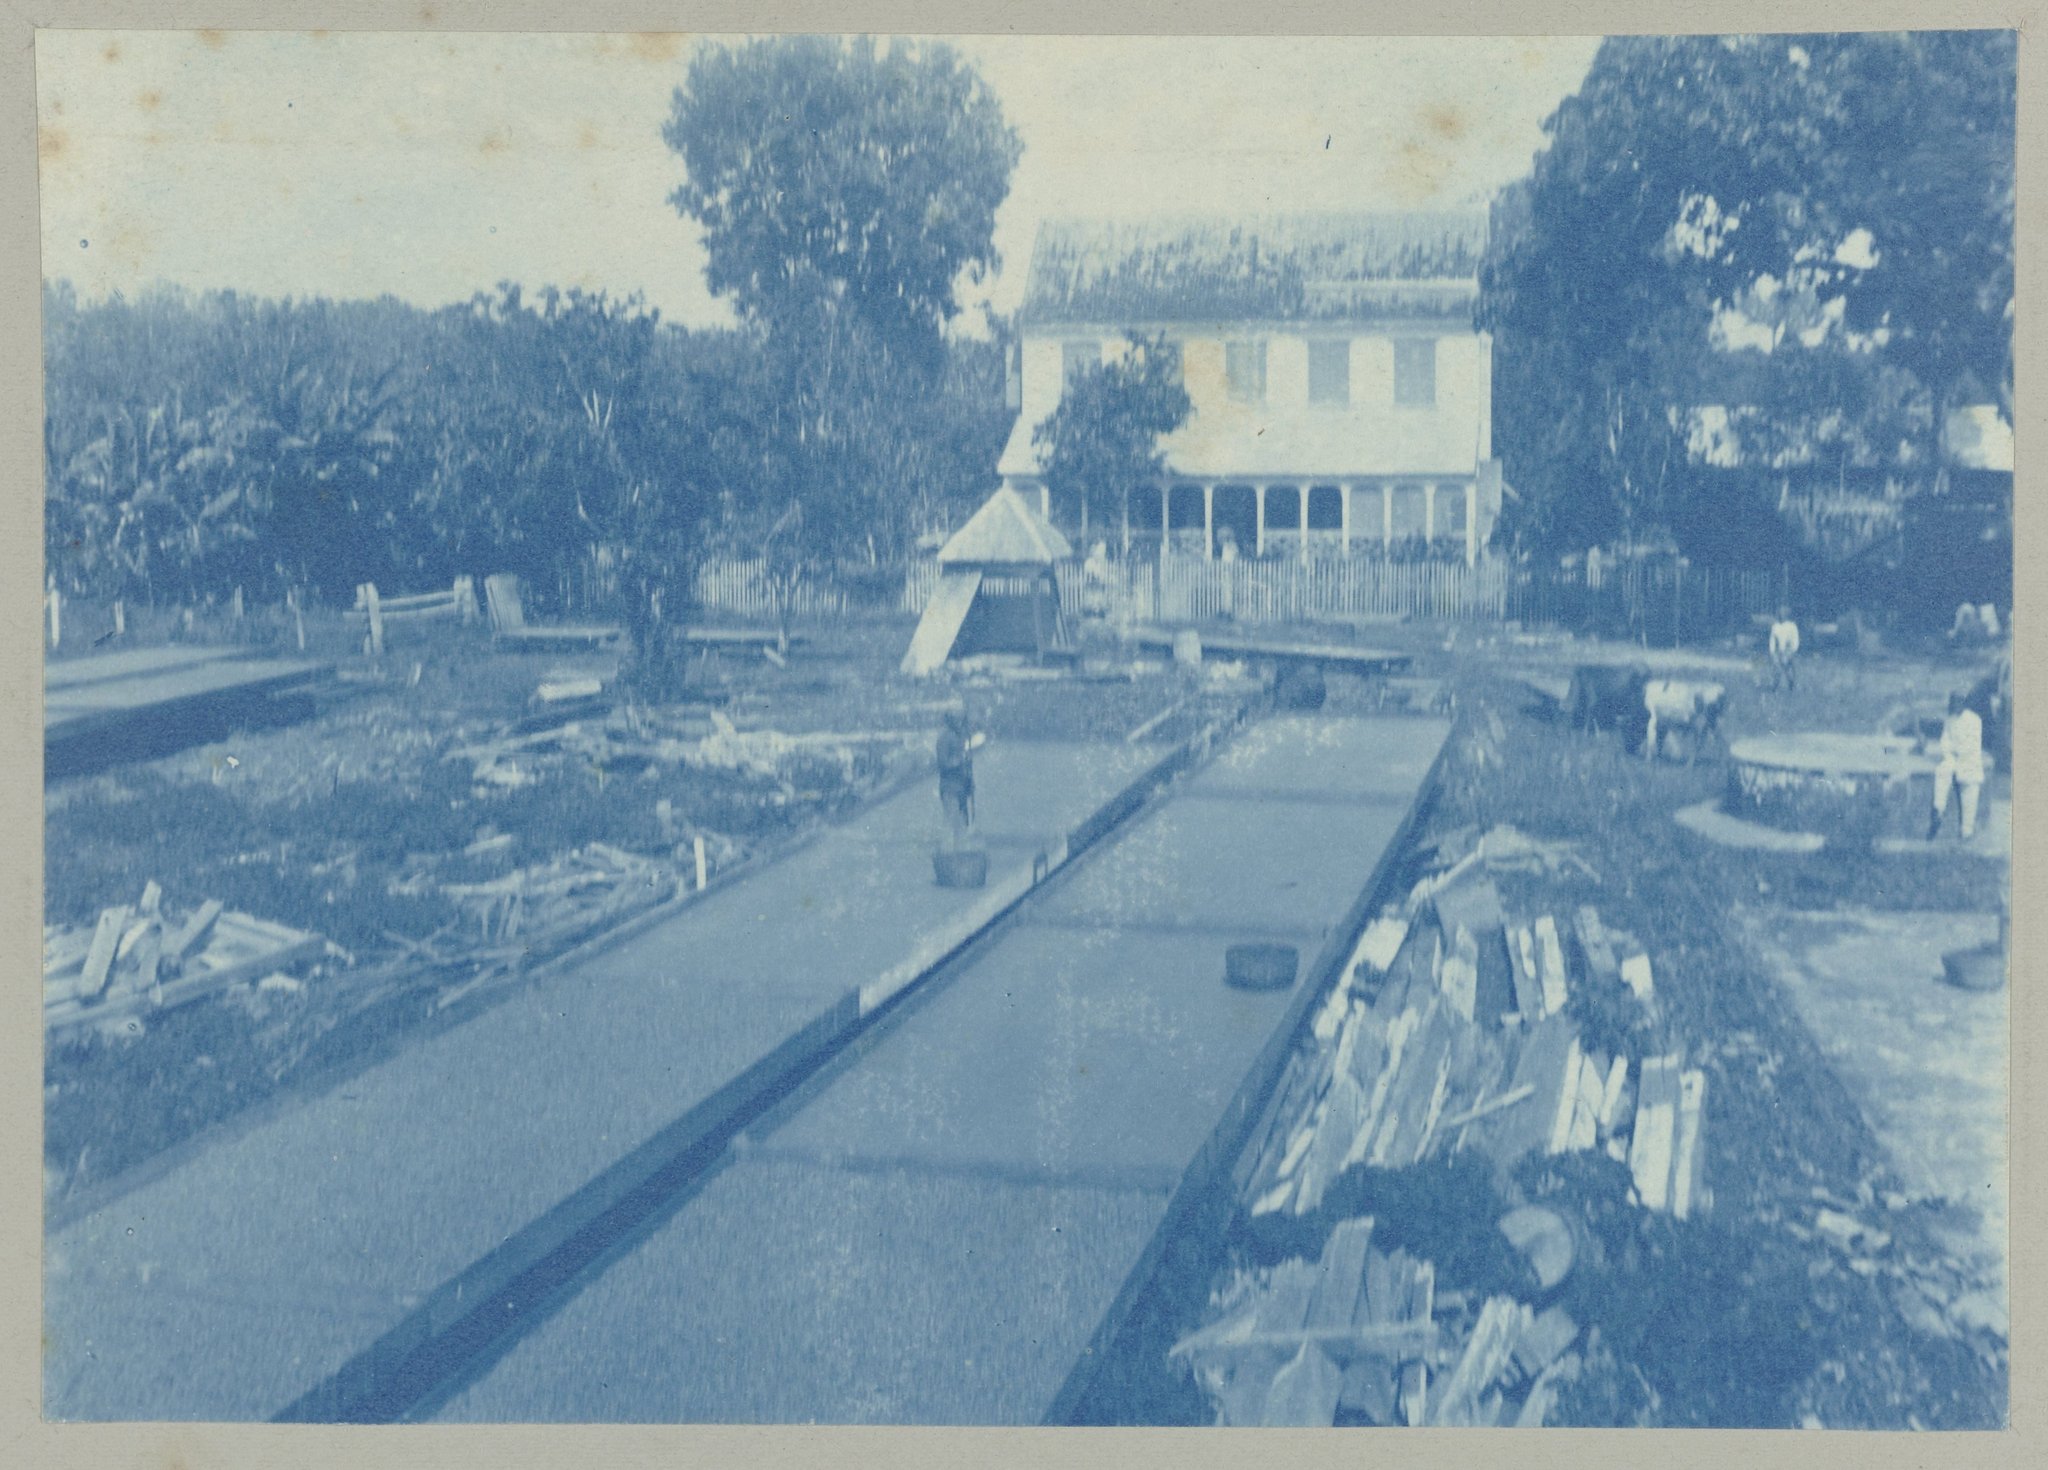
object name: photograph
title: Ma retraite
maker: hendrik doijer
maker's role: engineer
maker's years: 1863-1925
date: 1903-1910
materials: photographic support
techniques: cyanotype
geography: suriname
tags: suriname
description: Gezicht op het plantagehuis van Ma retraite. Voor het huis droogbakken met cacaobonen. Onderdeel van het fotoalbum Souvenir de Voyage (deel 2), over het leven van de familie Doijer in en rond de plantage Ma Retraite in Suriname in de jaren 1903-1910.